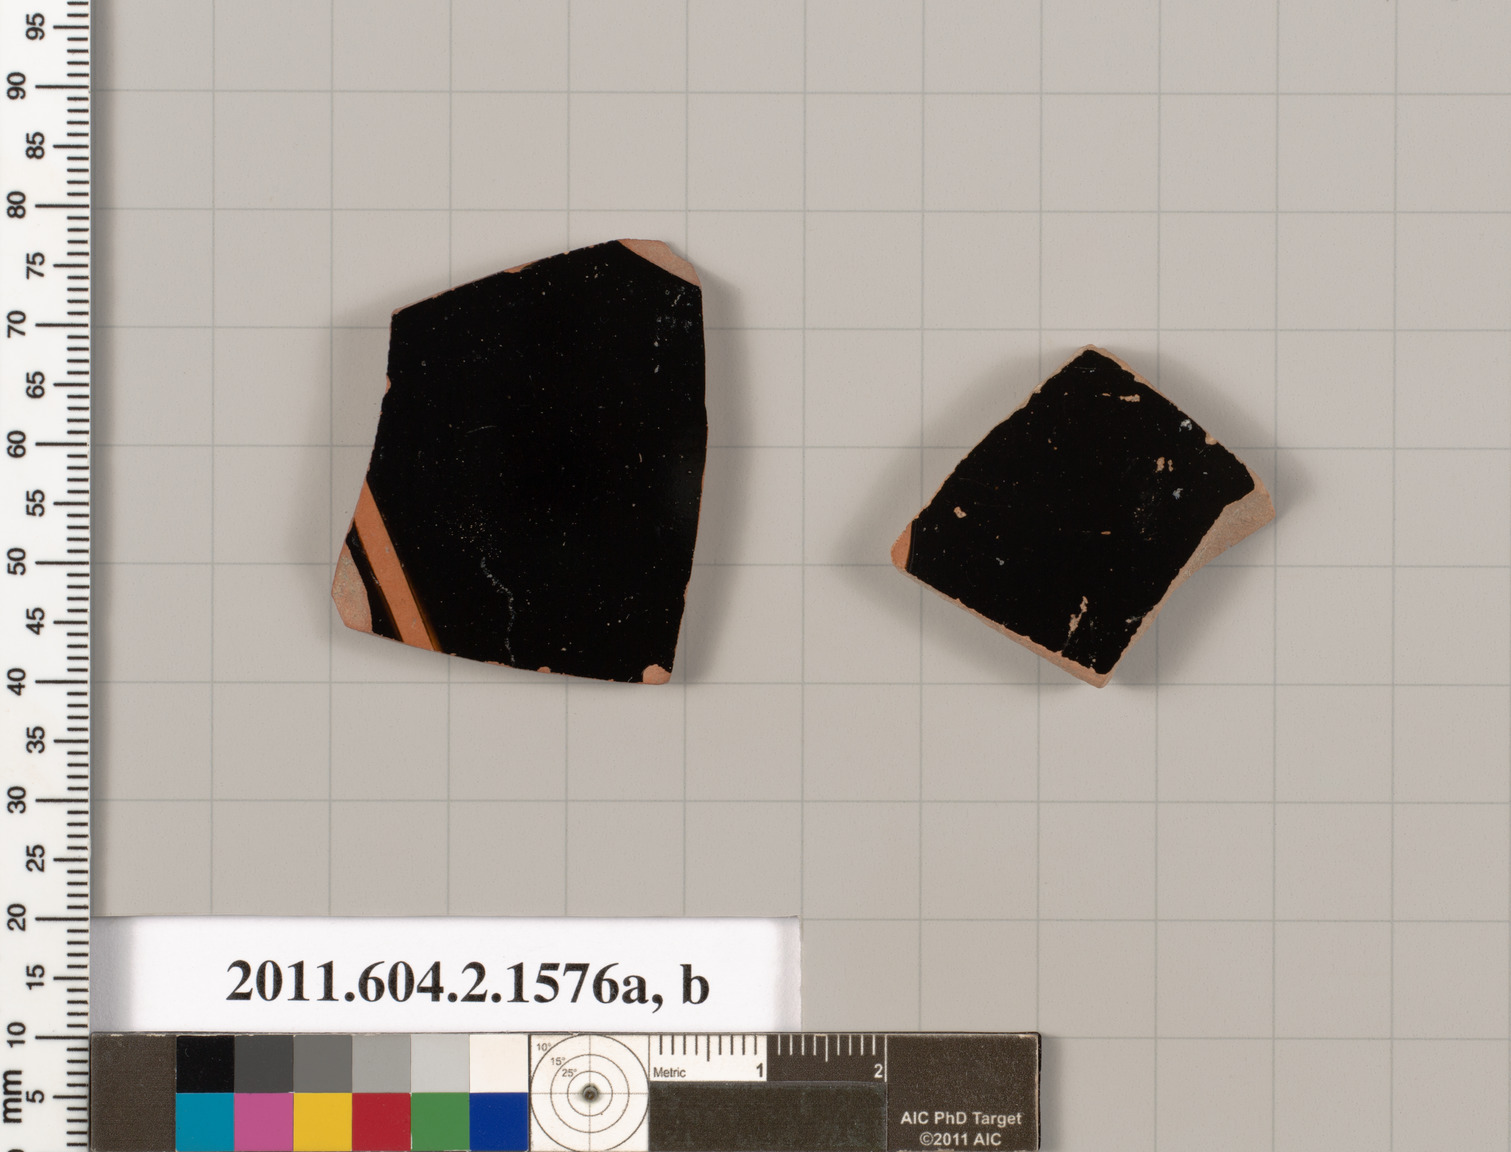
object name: skyphos fragment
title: Terracotta fragments of skyphoi (deep drinking cups)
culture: greek, attic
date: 475-451 BCE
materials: terracotta